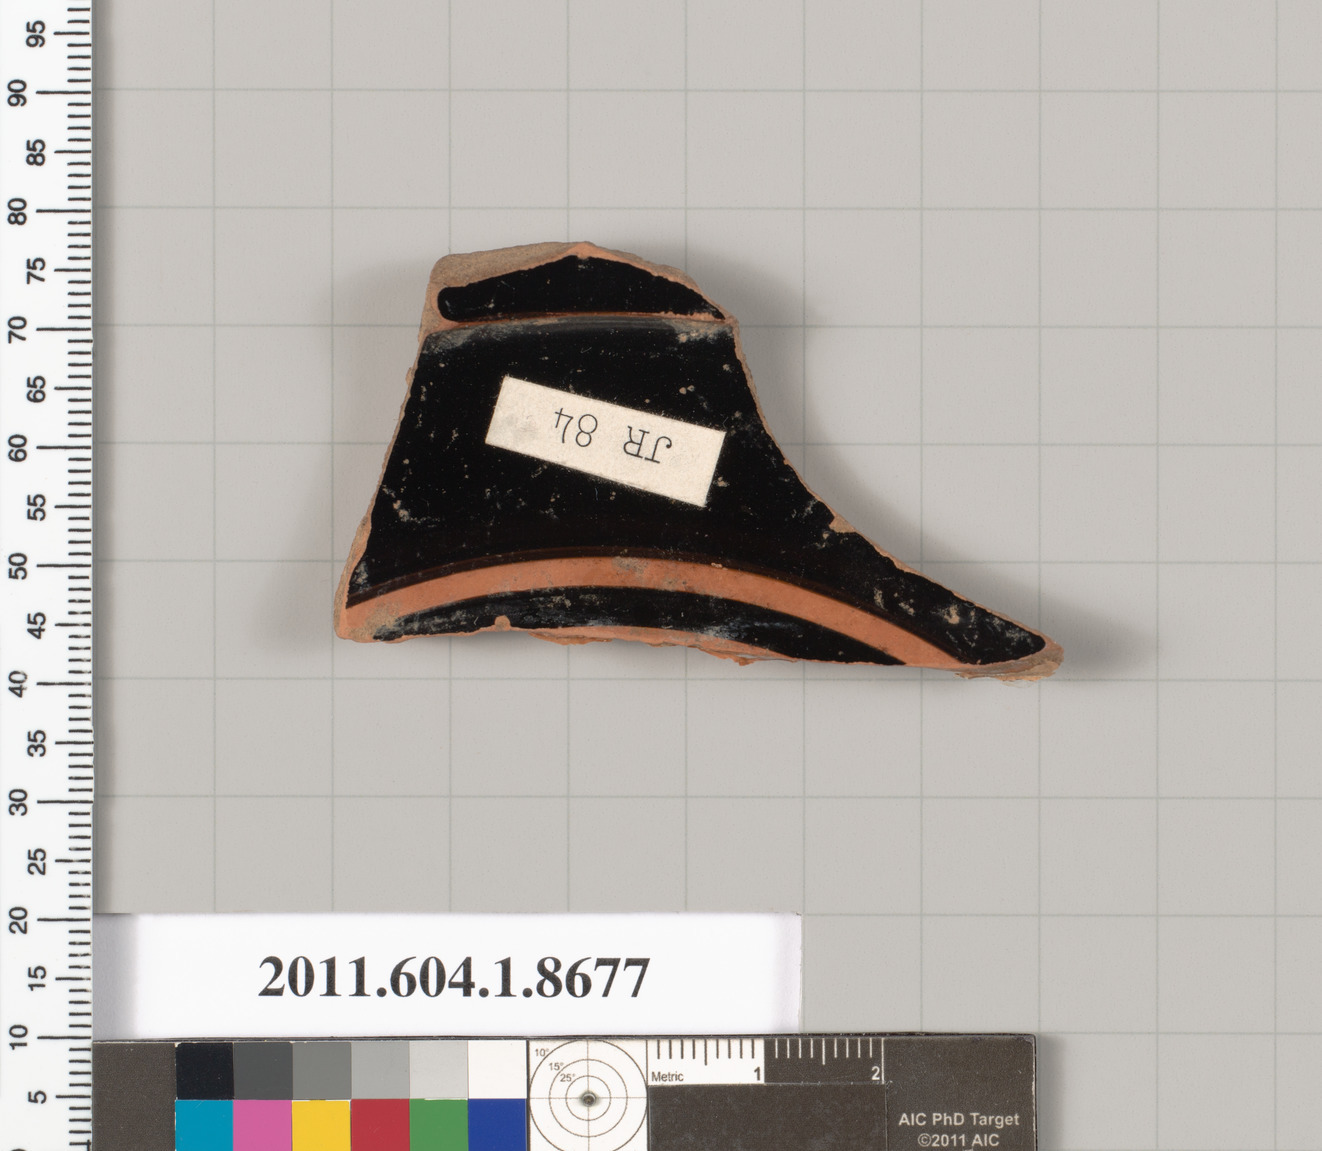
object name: kylix fragment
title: Terracotta fragment of a stemless kylix (drinking cup)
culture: greek, attic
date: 460-450 BCE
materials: terracotta